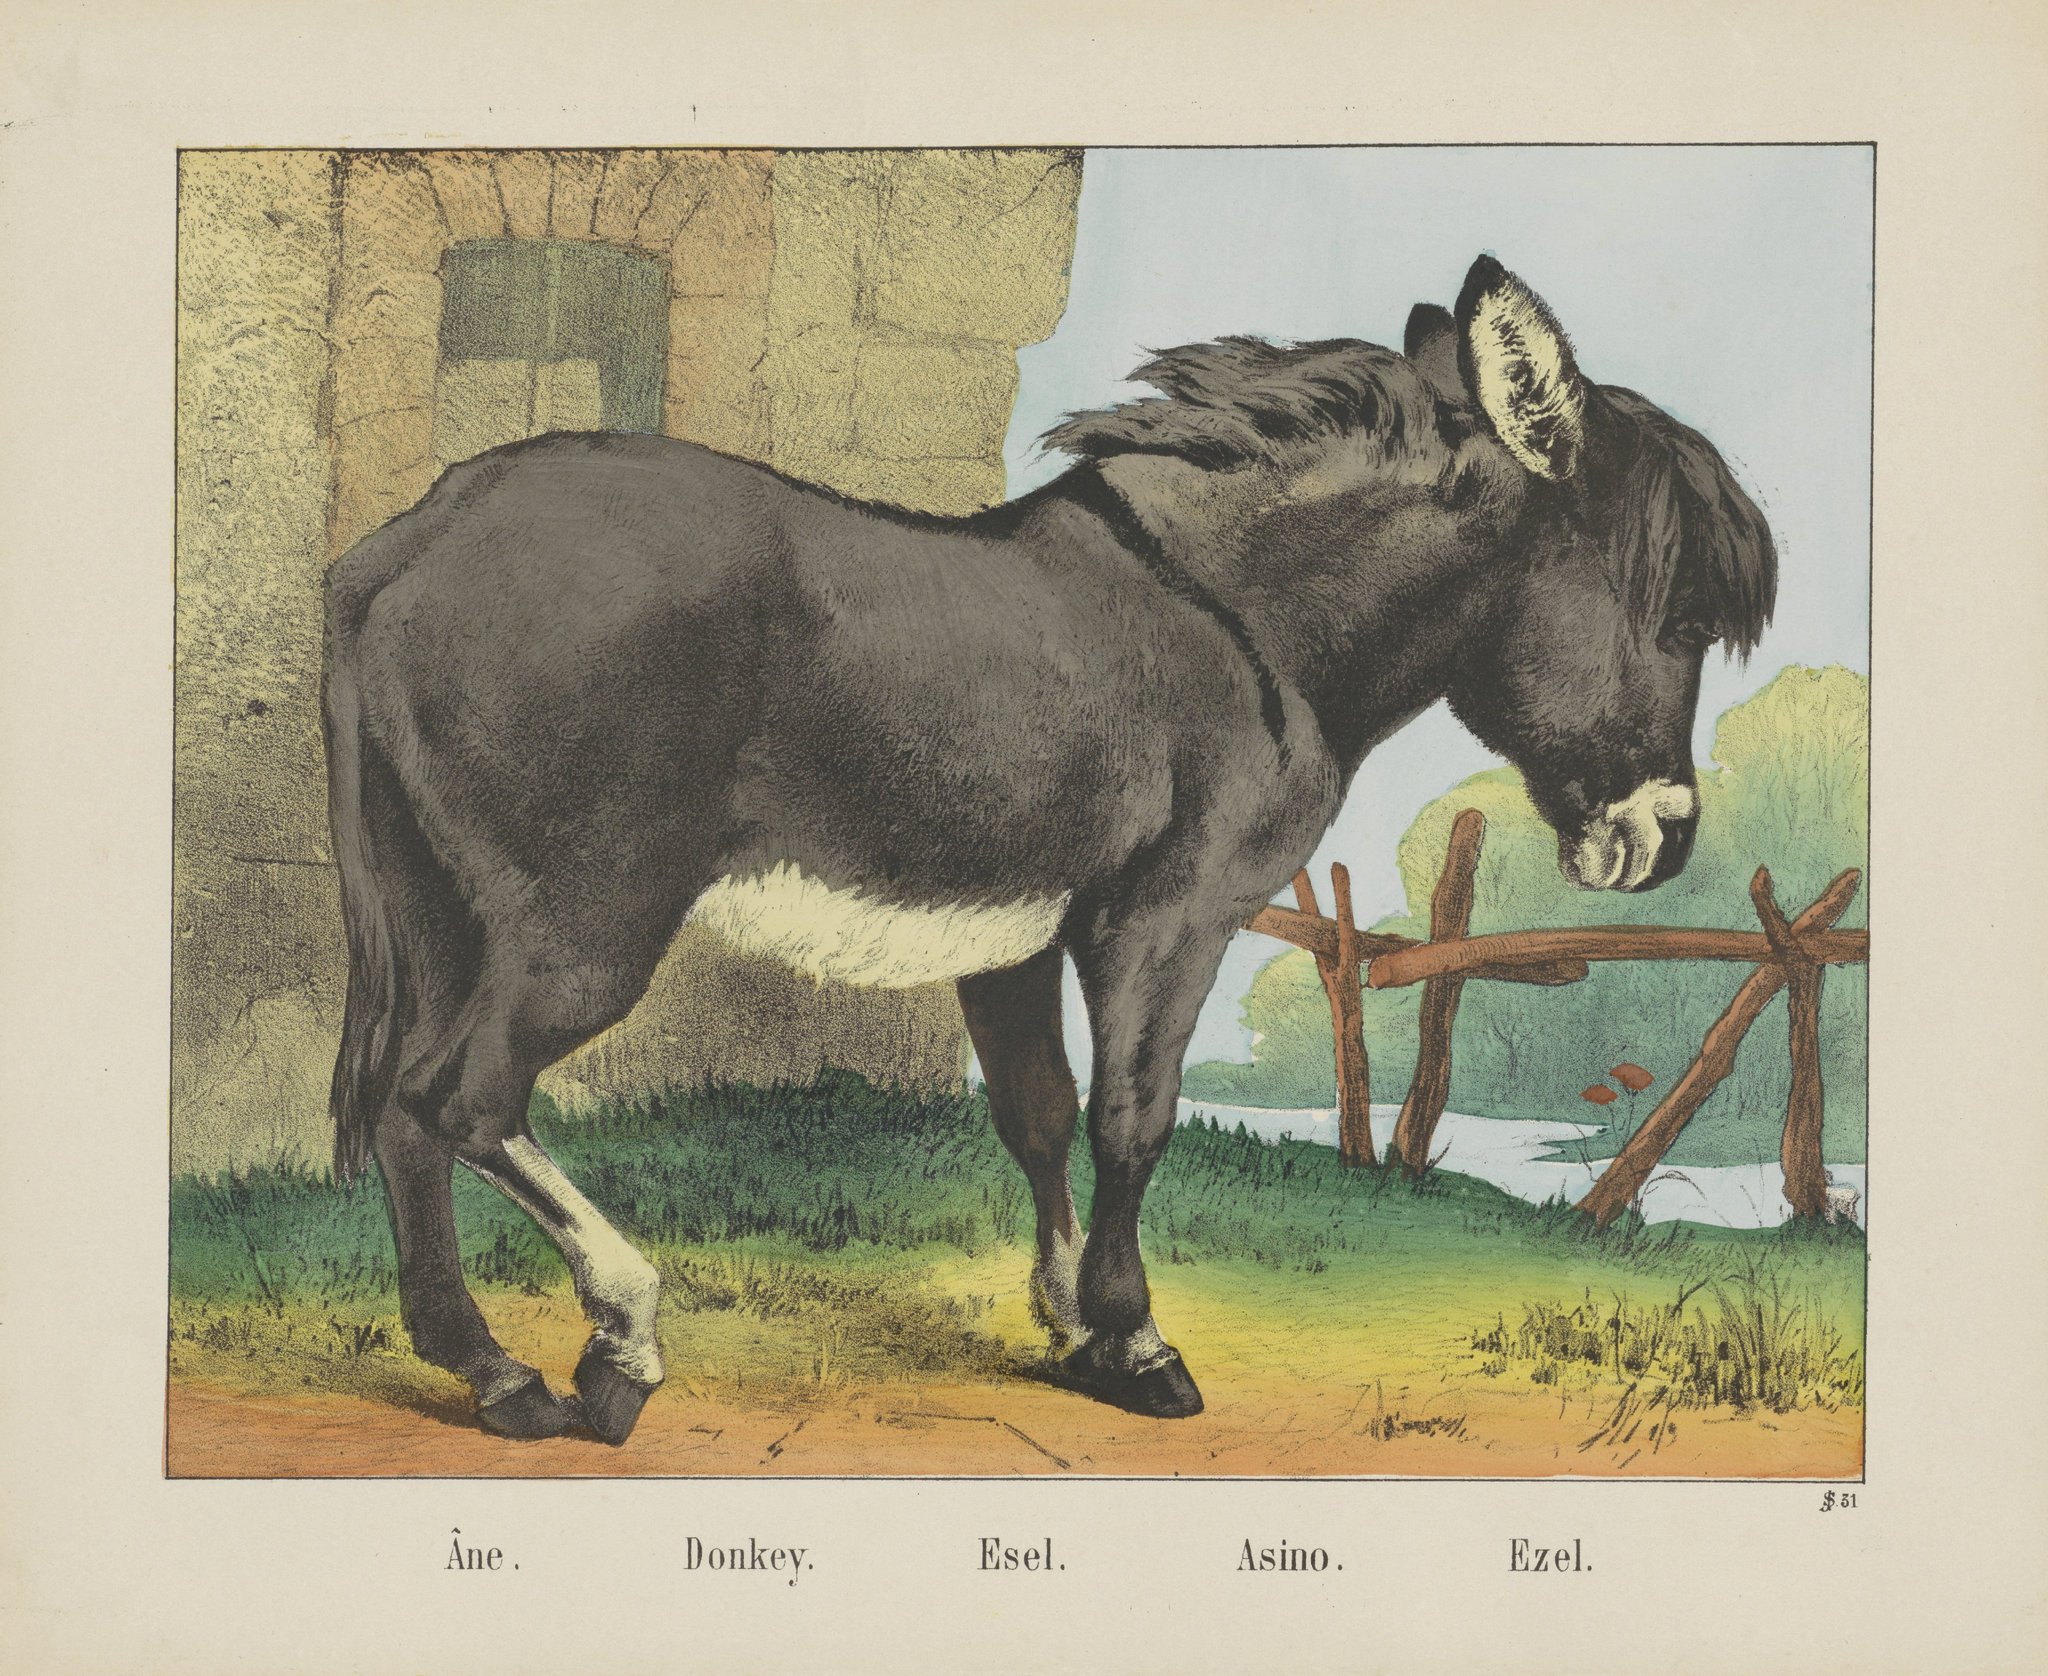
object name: popular print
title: Âne. / Donkey. / Esel. / Asino. / Ezel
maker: Anonymous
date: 1829-1880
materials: paper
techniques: colour, letterpress printing, lithograph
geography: mainz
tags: ass, donkey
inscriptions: collector's mark: Lugt 2760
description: Een ezel bij een hek. Genummerd rechtsonder: 31.